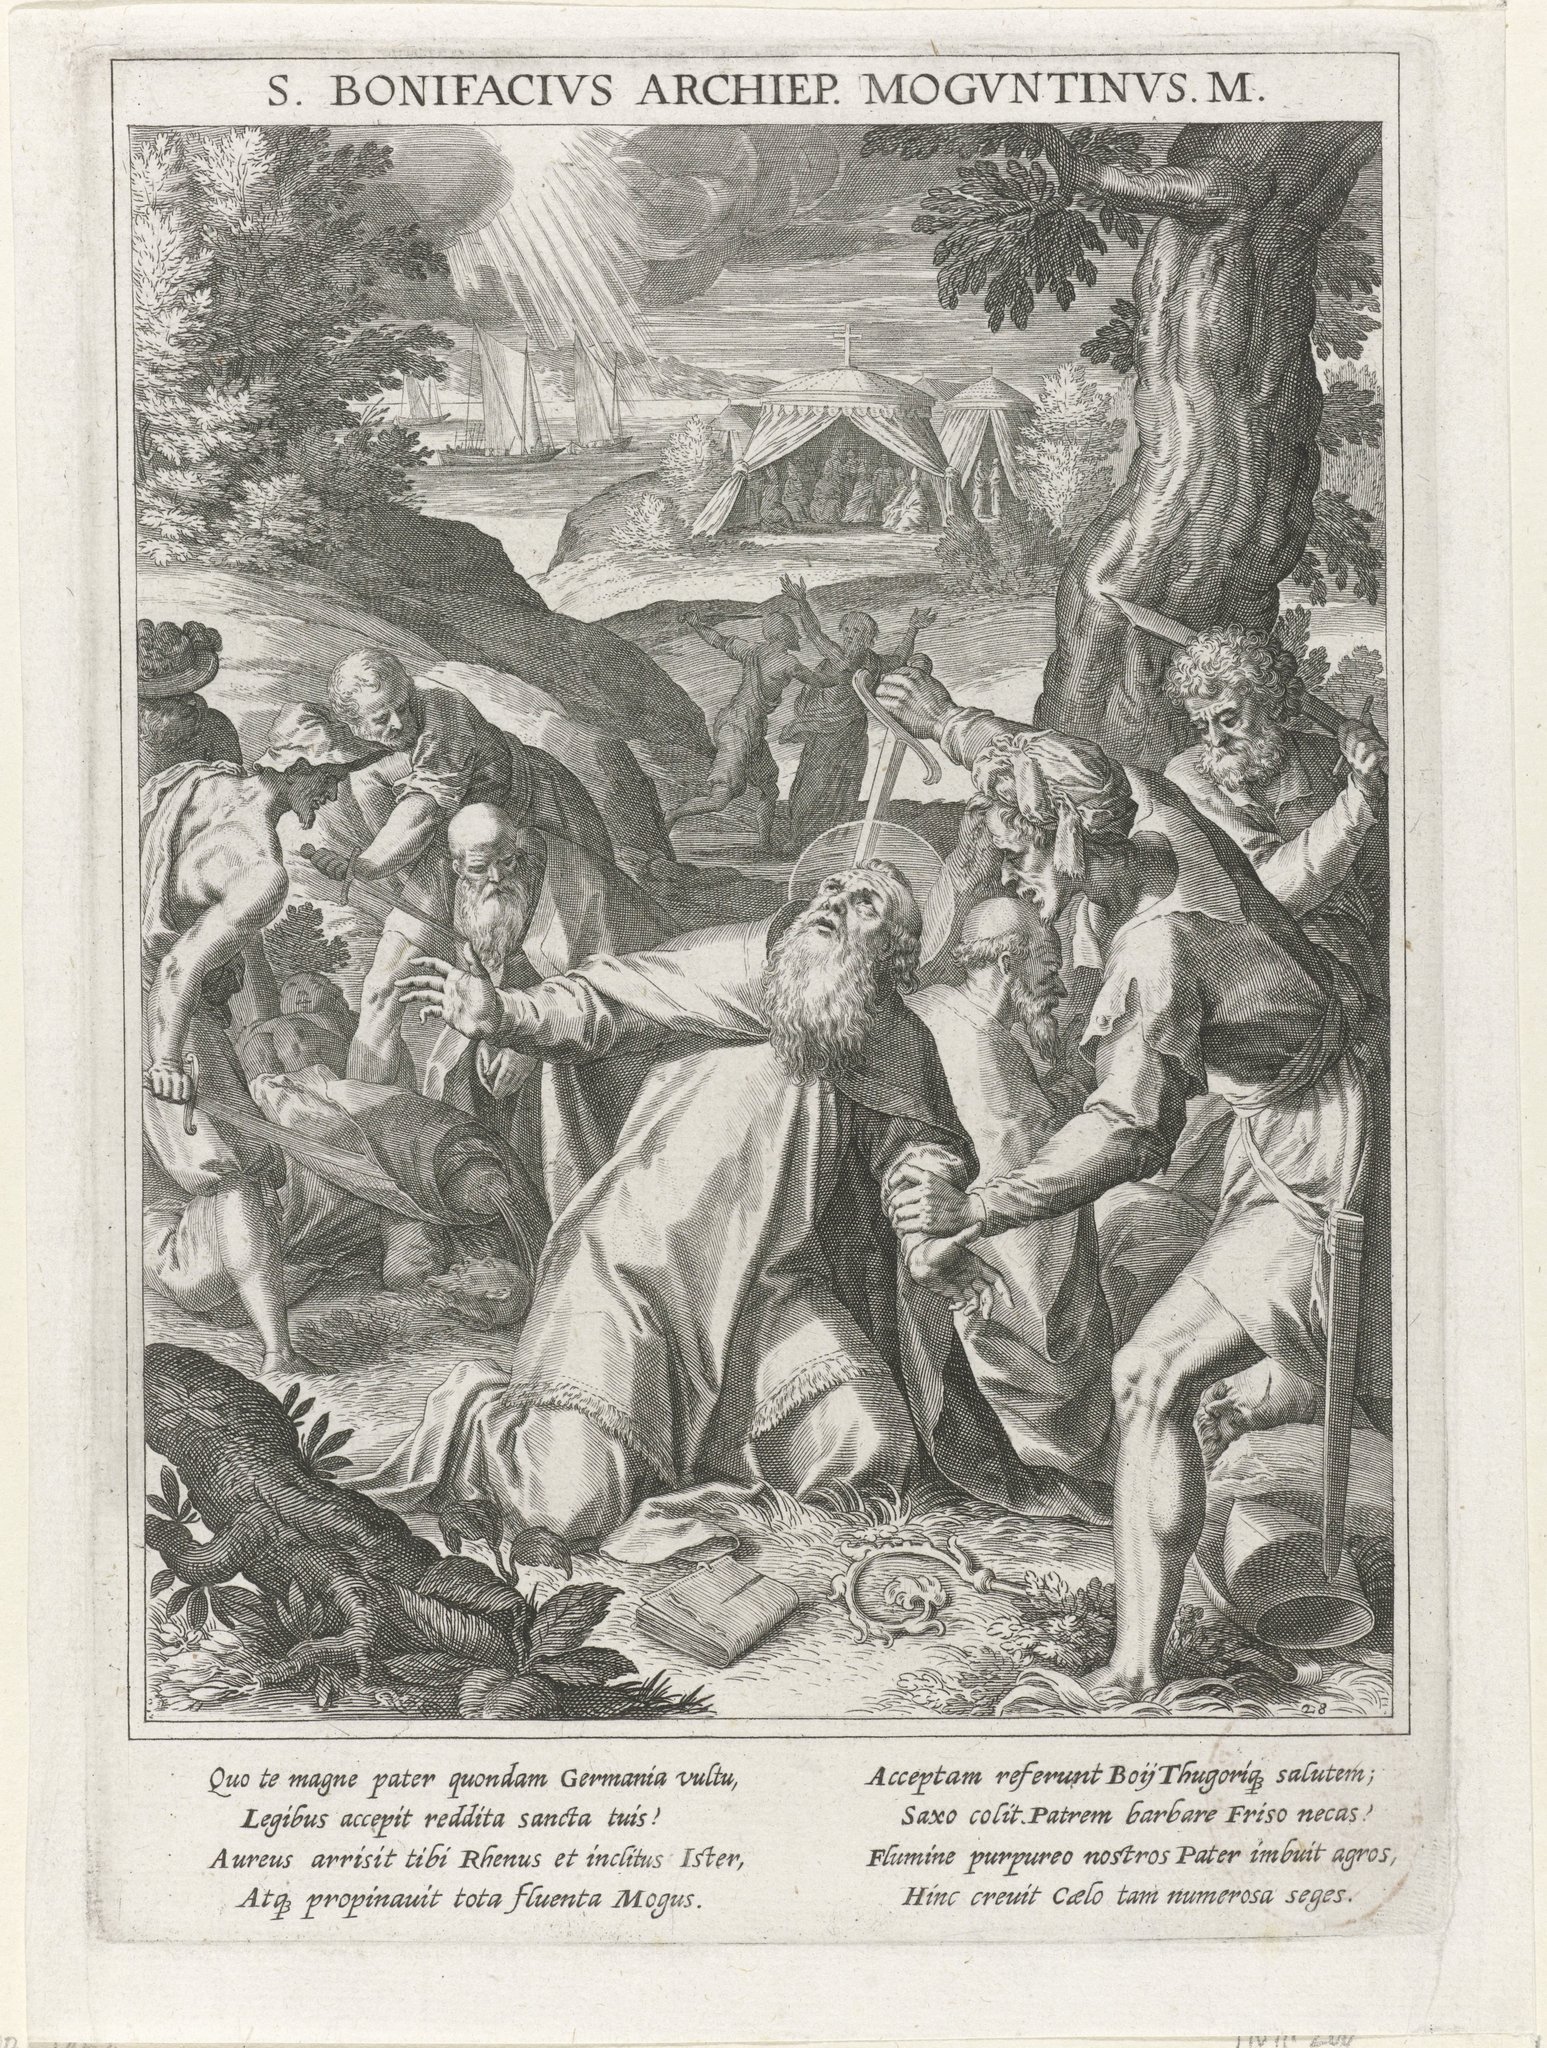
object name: print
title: Heiligen van Beieren I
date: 1615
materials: paper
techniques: engraving, etching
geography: munich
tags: st. boniface is killed by the sword near dokkum in frisia; he tries in vain to protect himself with a bible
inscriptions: collector's mark: Lugt 240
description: Op de voorgrond wordt de H. Bonifatius en zijn volgelingen door de Friezen vermoord. Op de achtergrond zijn tent in Dokkum. De prent heeft een Latijns onderschrift en is de 28ste prent van een 60-delige serie met als onderwerp de heiligen van Beieren.